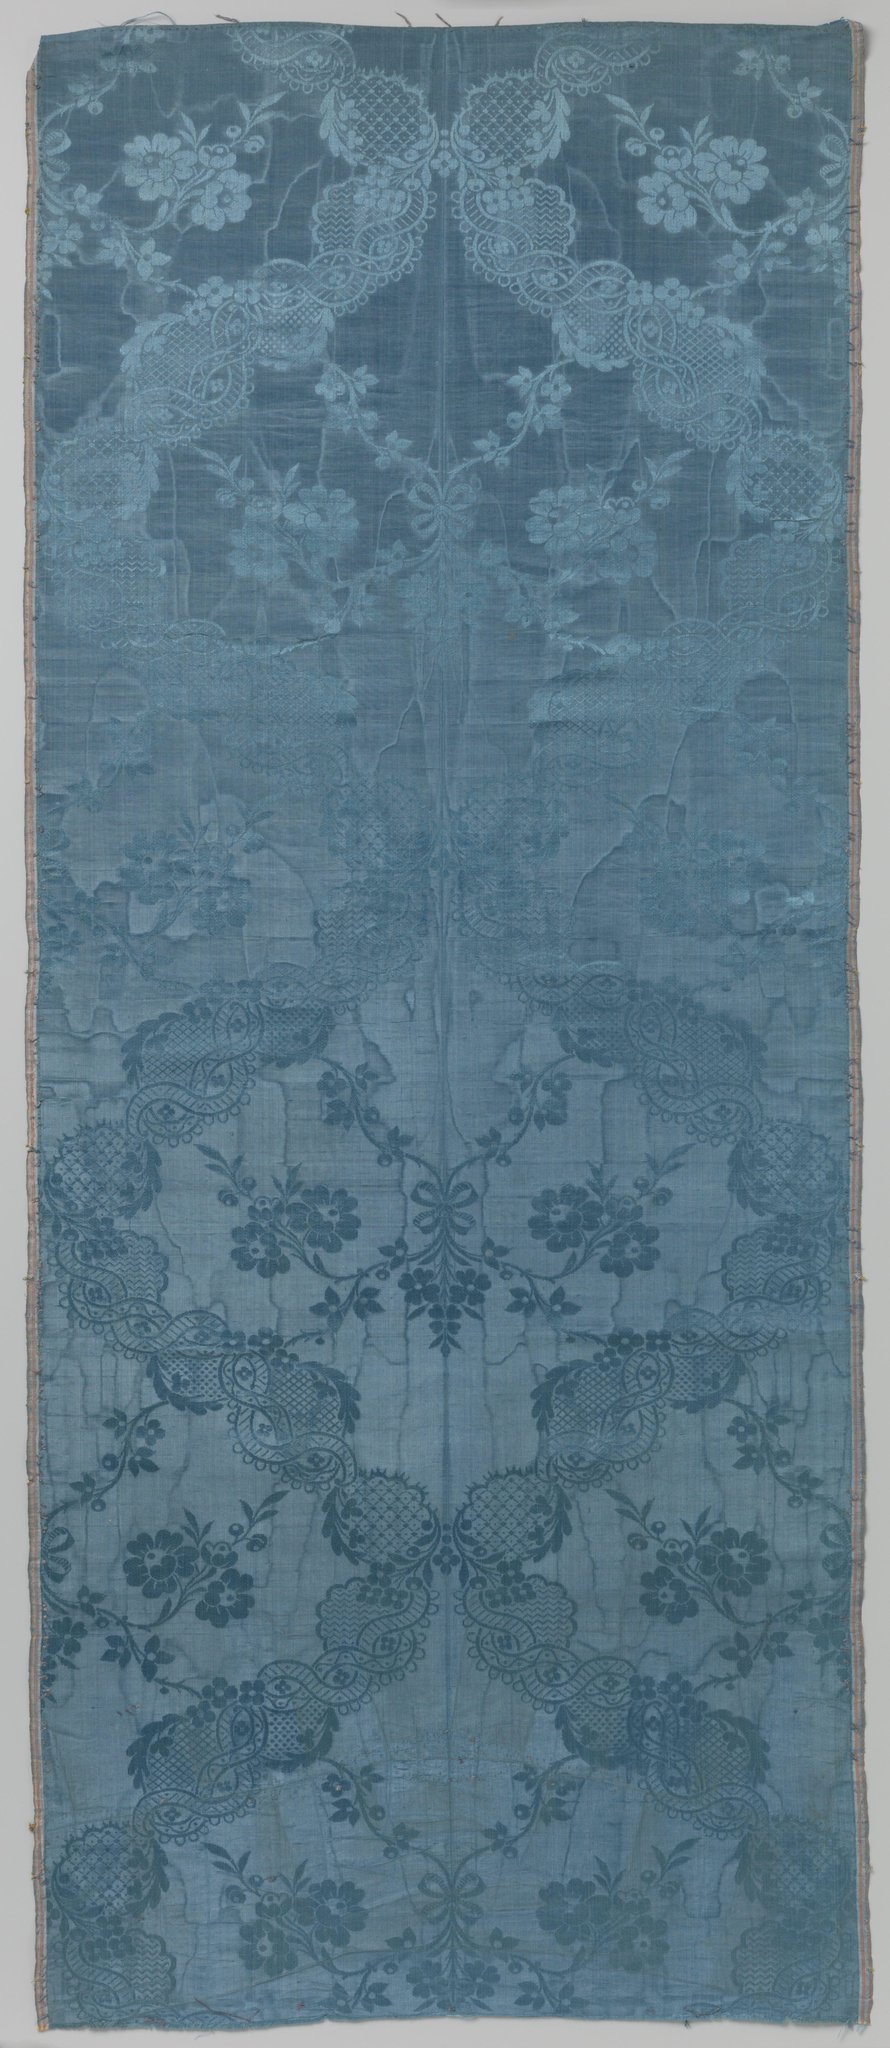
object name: zijdedamast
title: Fragment zijdedamast, blauw, met patroon van bloemen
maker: Anonymous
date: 1760-1770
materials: silk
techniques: damask, moire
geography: france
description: Fragmenten zijdedamast, blauw, met patroon van bloemen. In een brief uit 1976 van de heer C. Burgers, gevonden in de losse doucmentatie wordt over vier fragmenten gesproken.